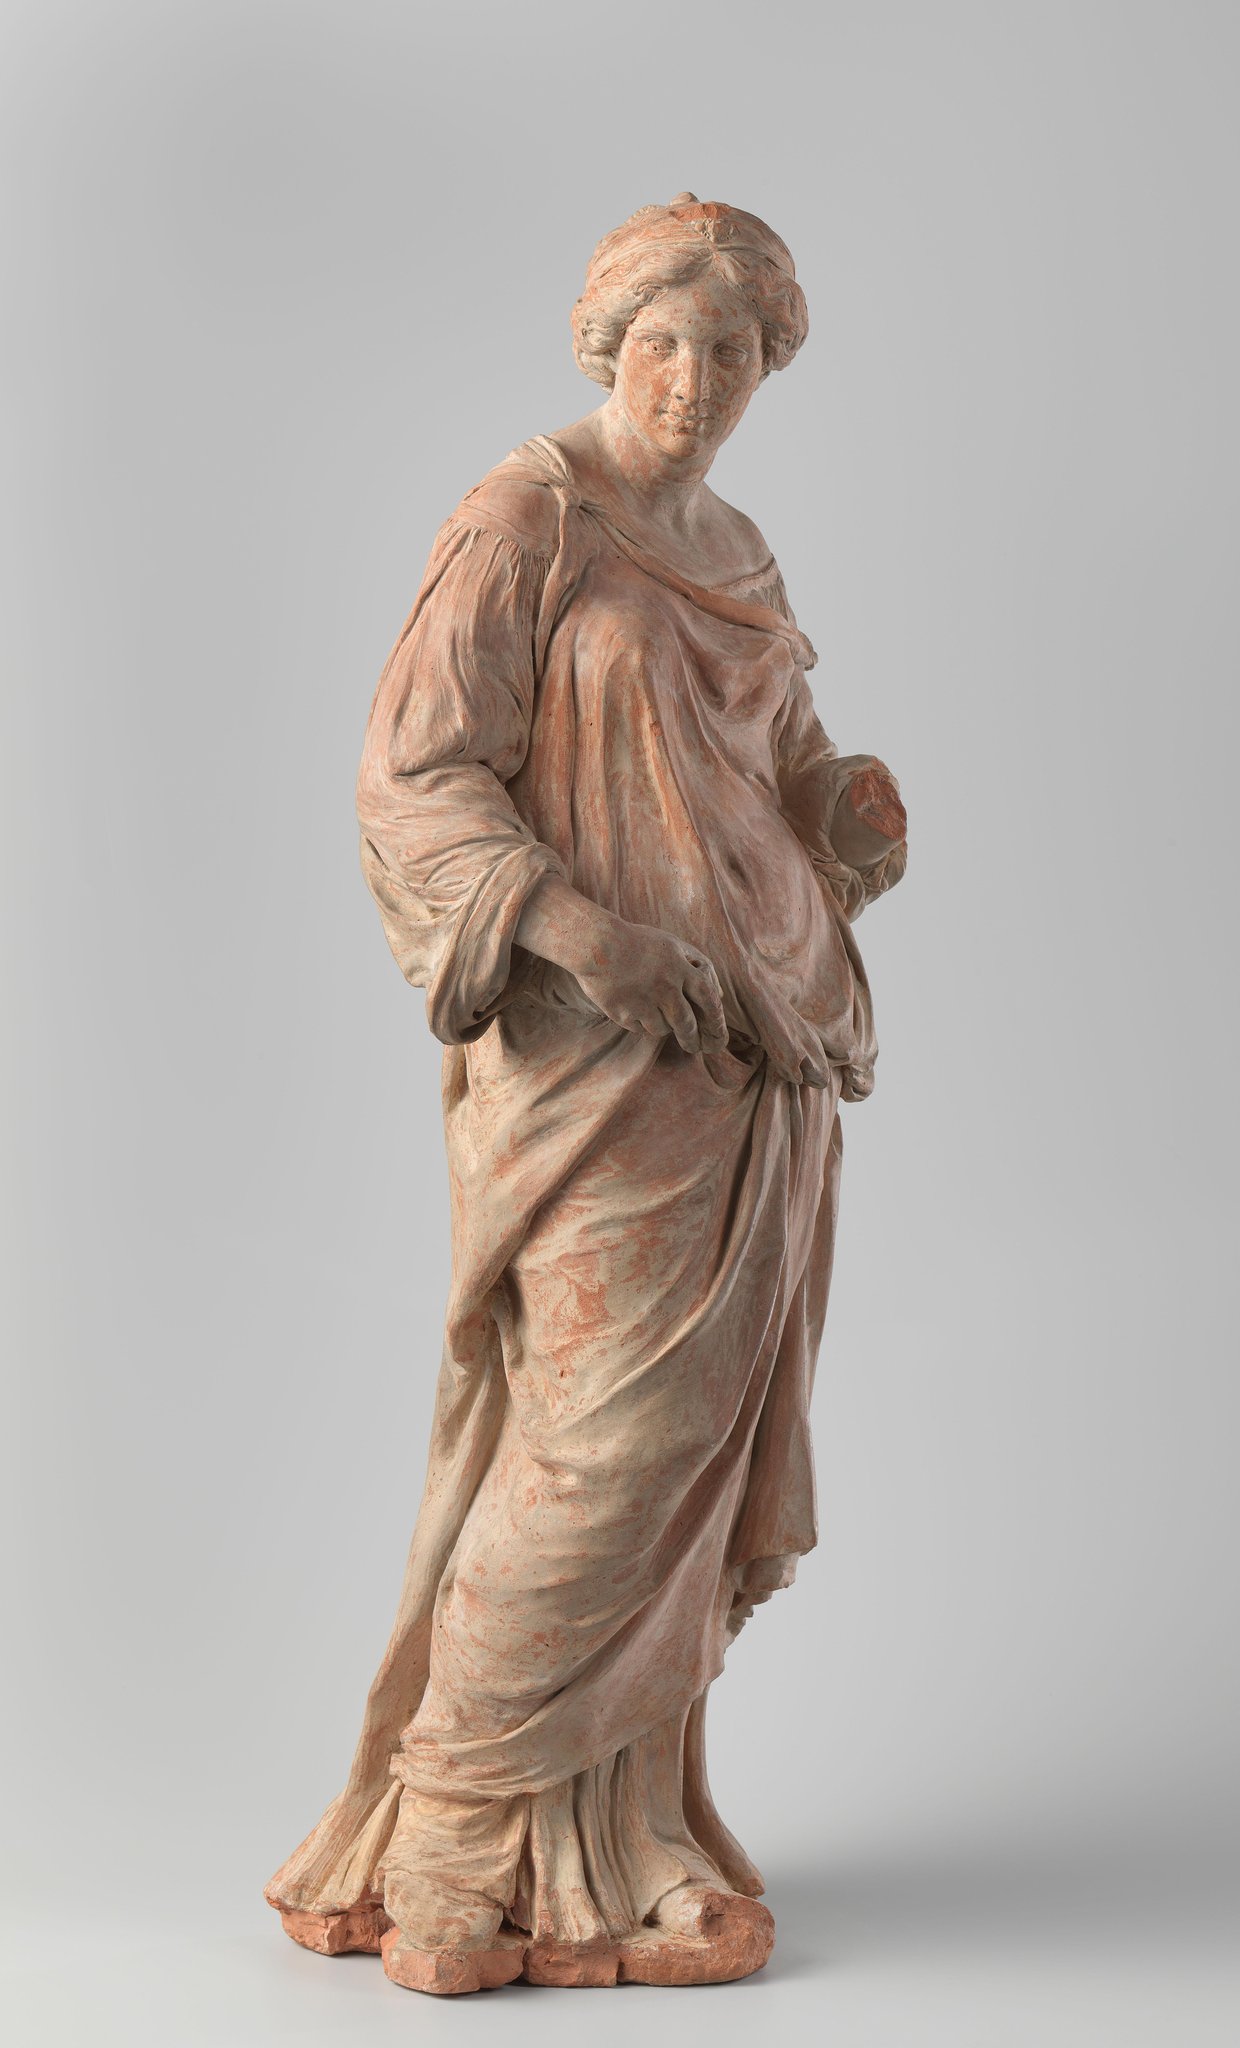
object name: sculpture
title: Justitia, Model for a Statue on the East Facade of the Amsterdam Town Hall (now Royal Palace) at Dam Square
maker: artus quellinus (i)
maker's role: draughtsman, print maker, sculptor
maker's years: 1609-1668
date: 1650-1651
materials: terracotta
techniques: modeling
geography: amsterdam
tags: justice, 'justitia'; 'giustitia divina' (ripa) ~ one of the four cardinal virtues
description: Both façades of the Town Hall are surmounted by three bronze statues. On the front elevation, Peace is flanked by the virtues Wisdom and Justice, of which these terracotta figures are the scale models. On the rear elevation, Atlas shoulders the celestial globe, with Temperance and Vigilance at his side. The message expressed here is that universal peace, on earth and in heaven, depends on these four virtues.